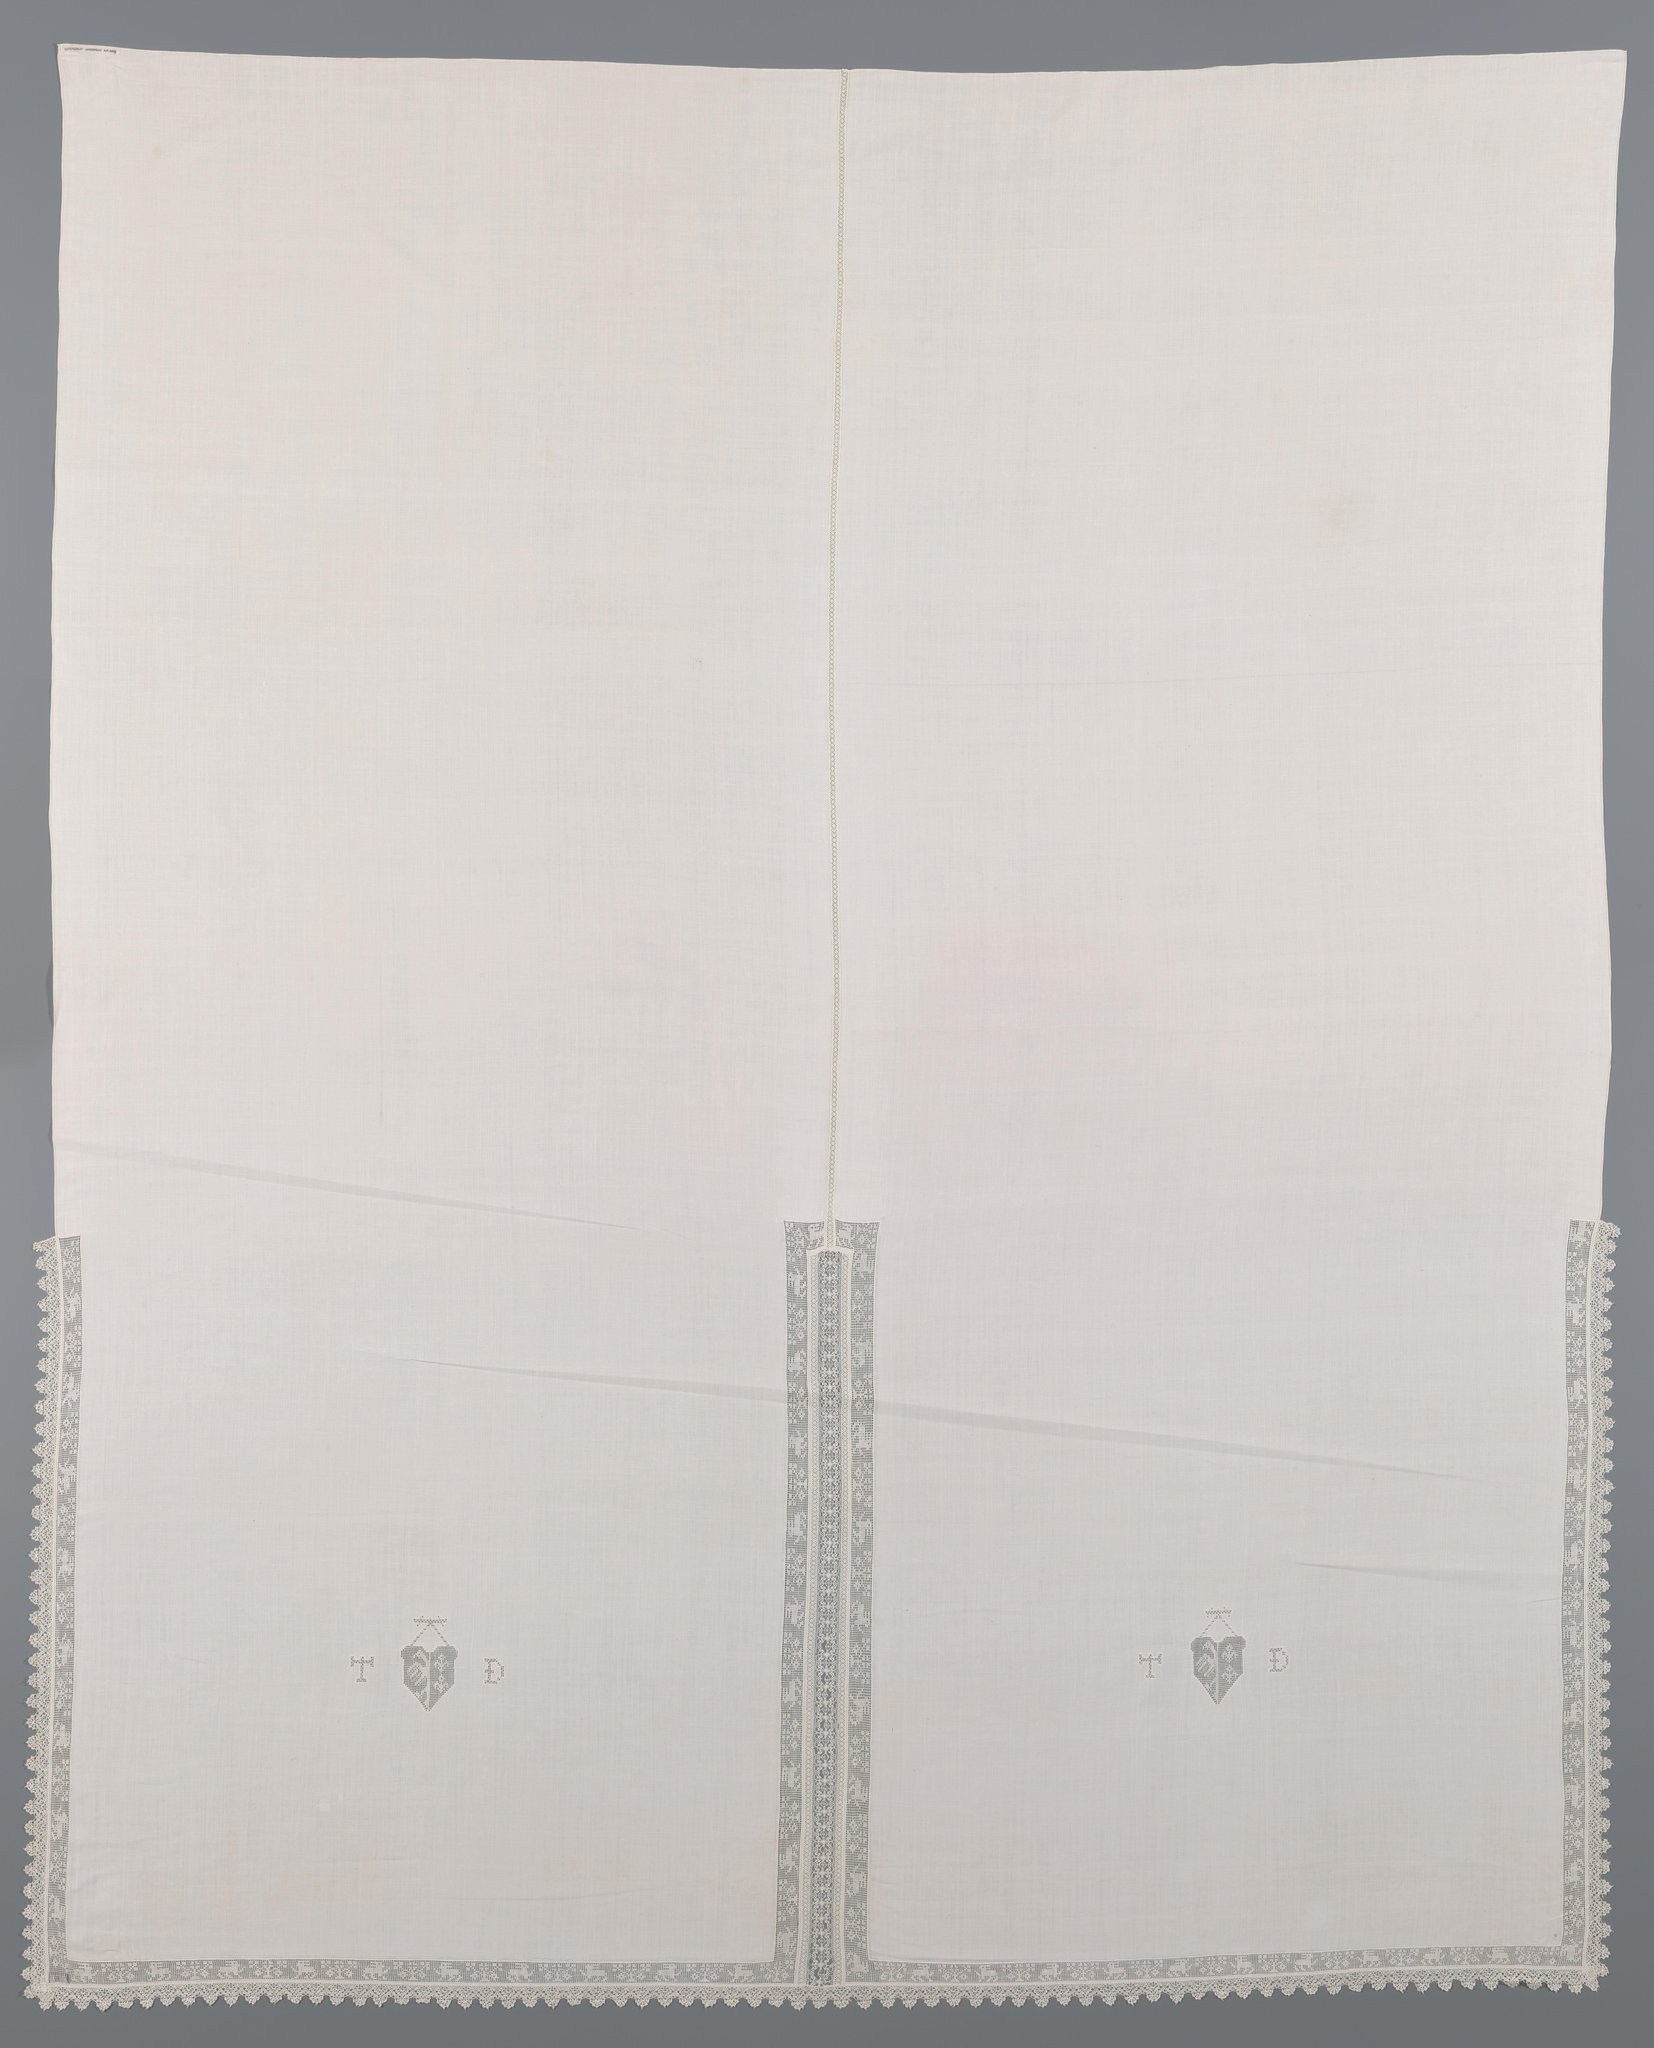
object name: beddenlaken, laken object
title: Laken met met het wapen van de familie Van Dekema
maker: Anonymous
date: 1600-1625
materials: linen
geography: netherlands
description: Het laken is waarschijnlijk vervaardigd voor dr. Sicke van Dekema (1548-1625), heer van Tammingaborg te Hornhuizen in de Marne en eigenaar van Mammemastate in Jellum (Friesland). De initialen TD die het Van Dekemawapen flankeren staan voor Tammingaborg Dekema.